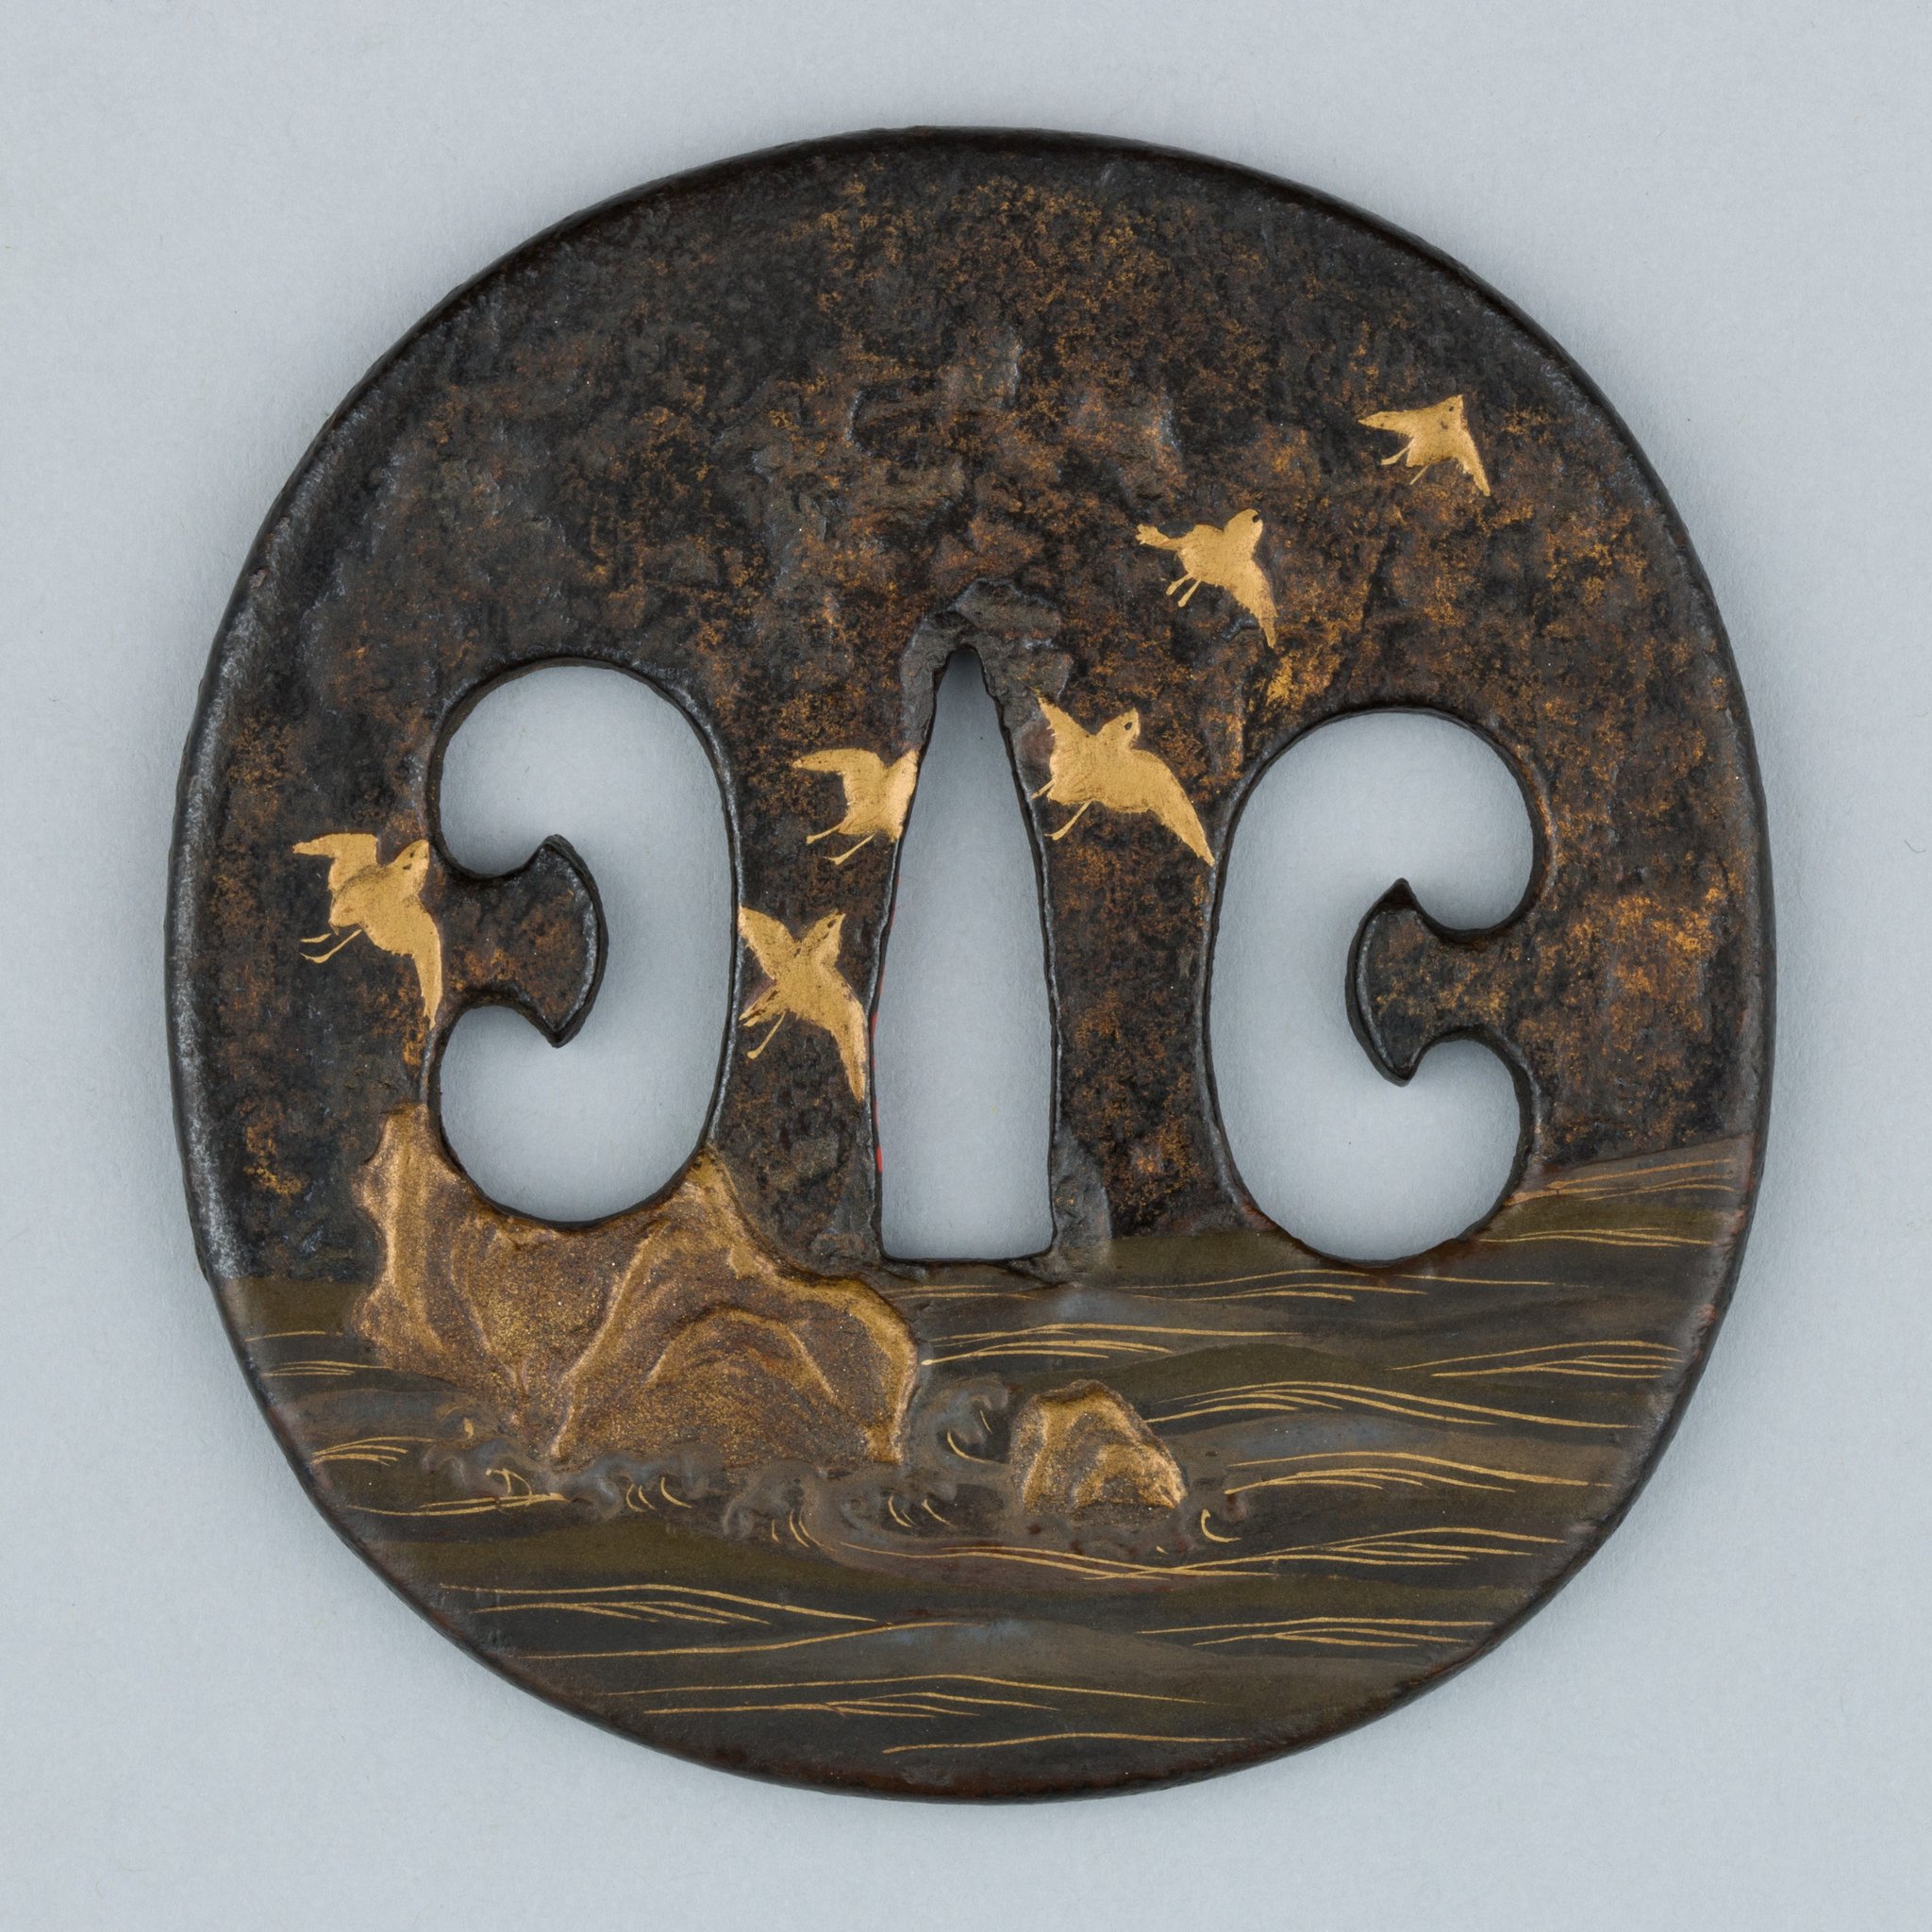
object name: sword guard tsuba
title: Sword Guard (Tsuba)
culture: japanese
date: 1701-1800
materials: copper, iron, lacquer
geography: japan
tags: birds